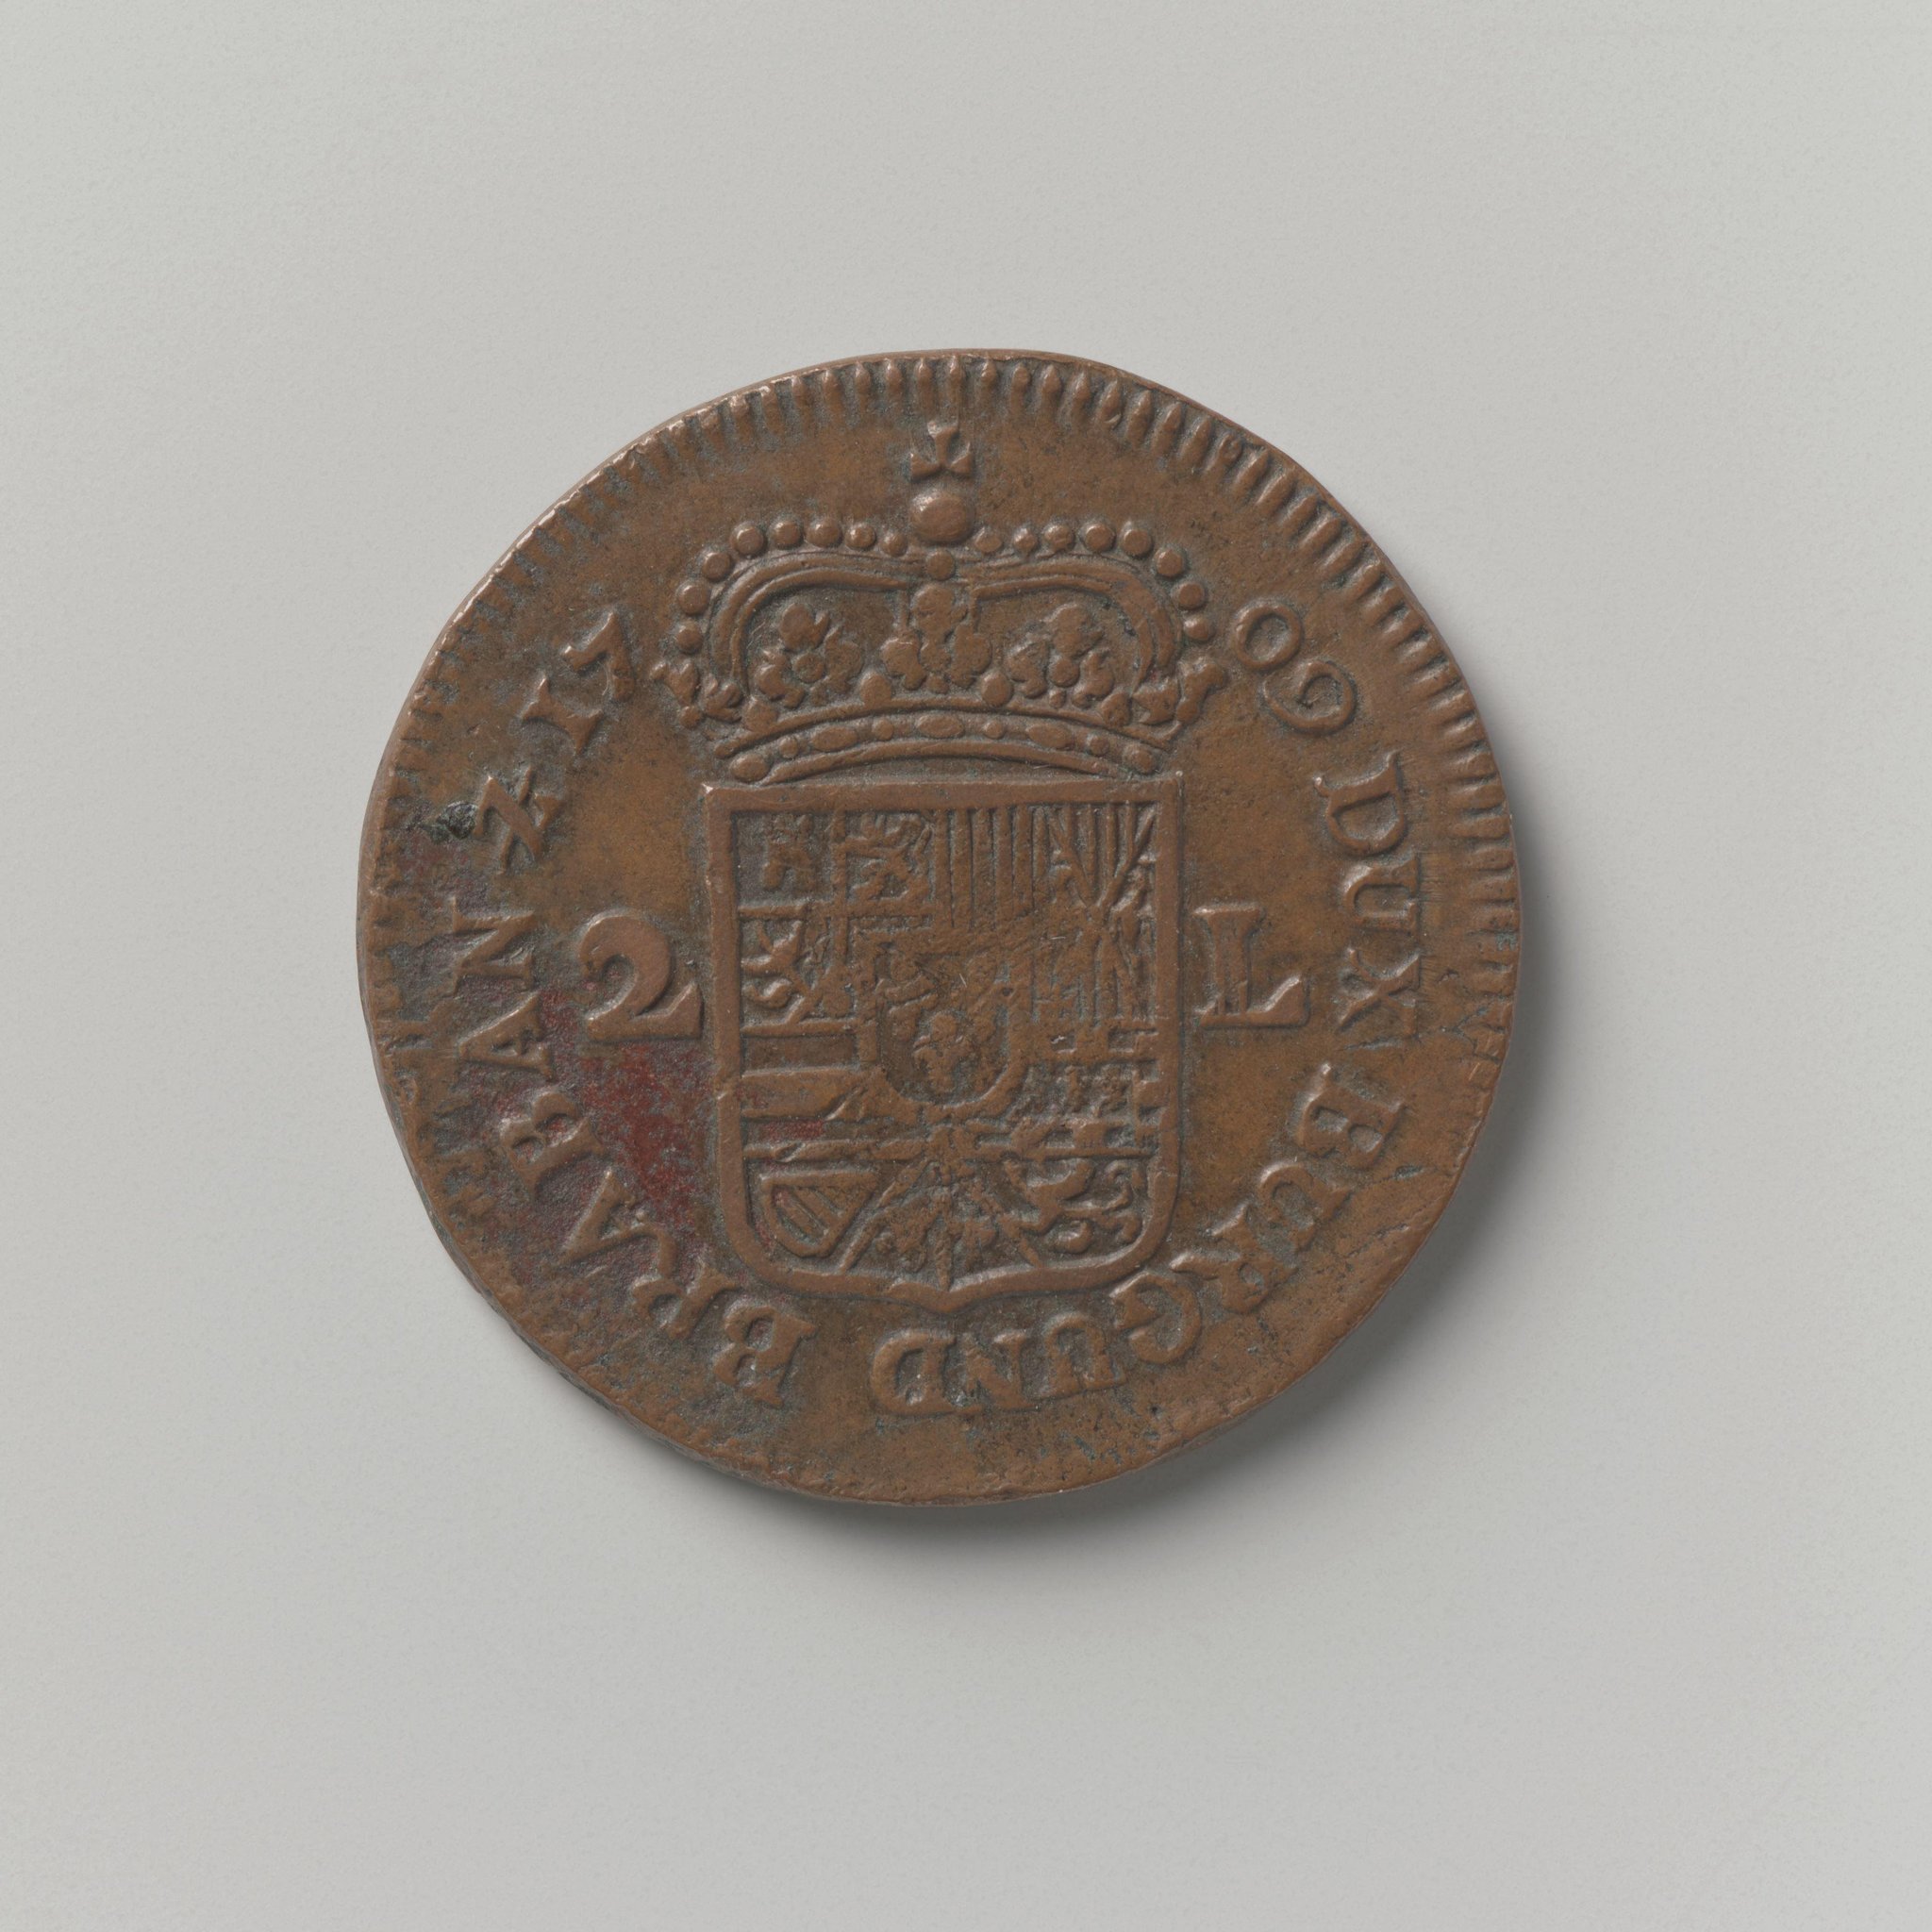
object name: coin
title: Dubbele oord uit Namen van Philips V, 1709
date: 1709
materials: copper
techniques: striking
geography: namur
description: Koperen munt. Voorzijde: portret van Philips V naar rechts. Leeuw onder portret. Keerzijde: tussen waarde-aaanduiding gekroond samengesteld wapenschild. Jaartal rondom kroon.